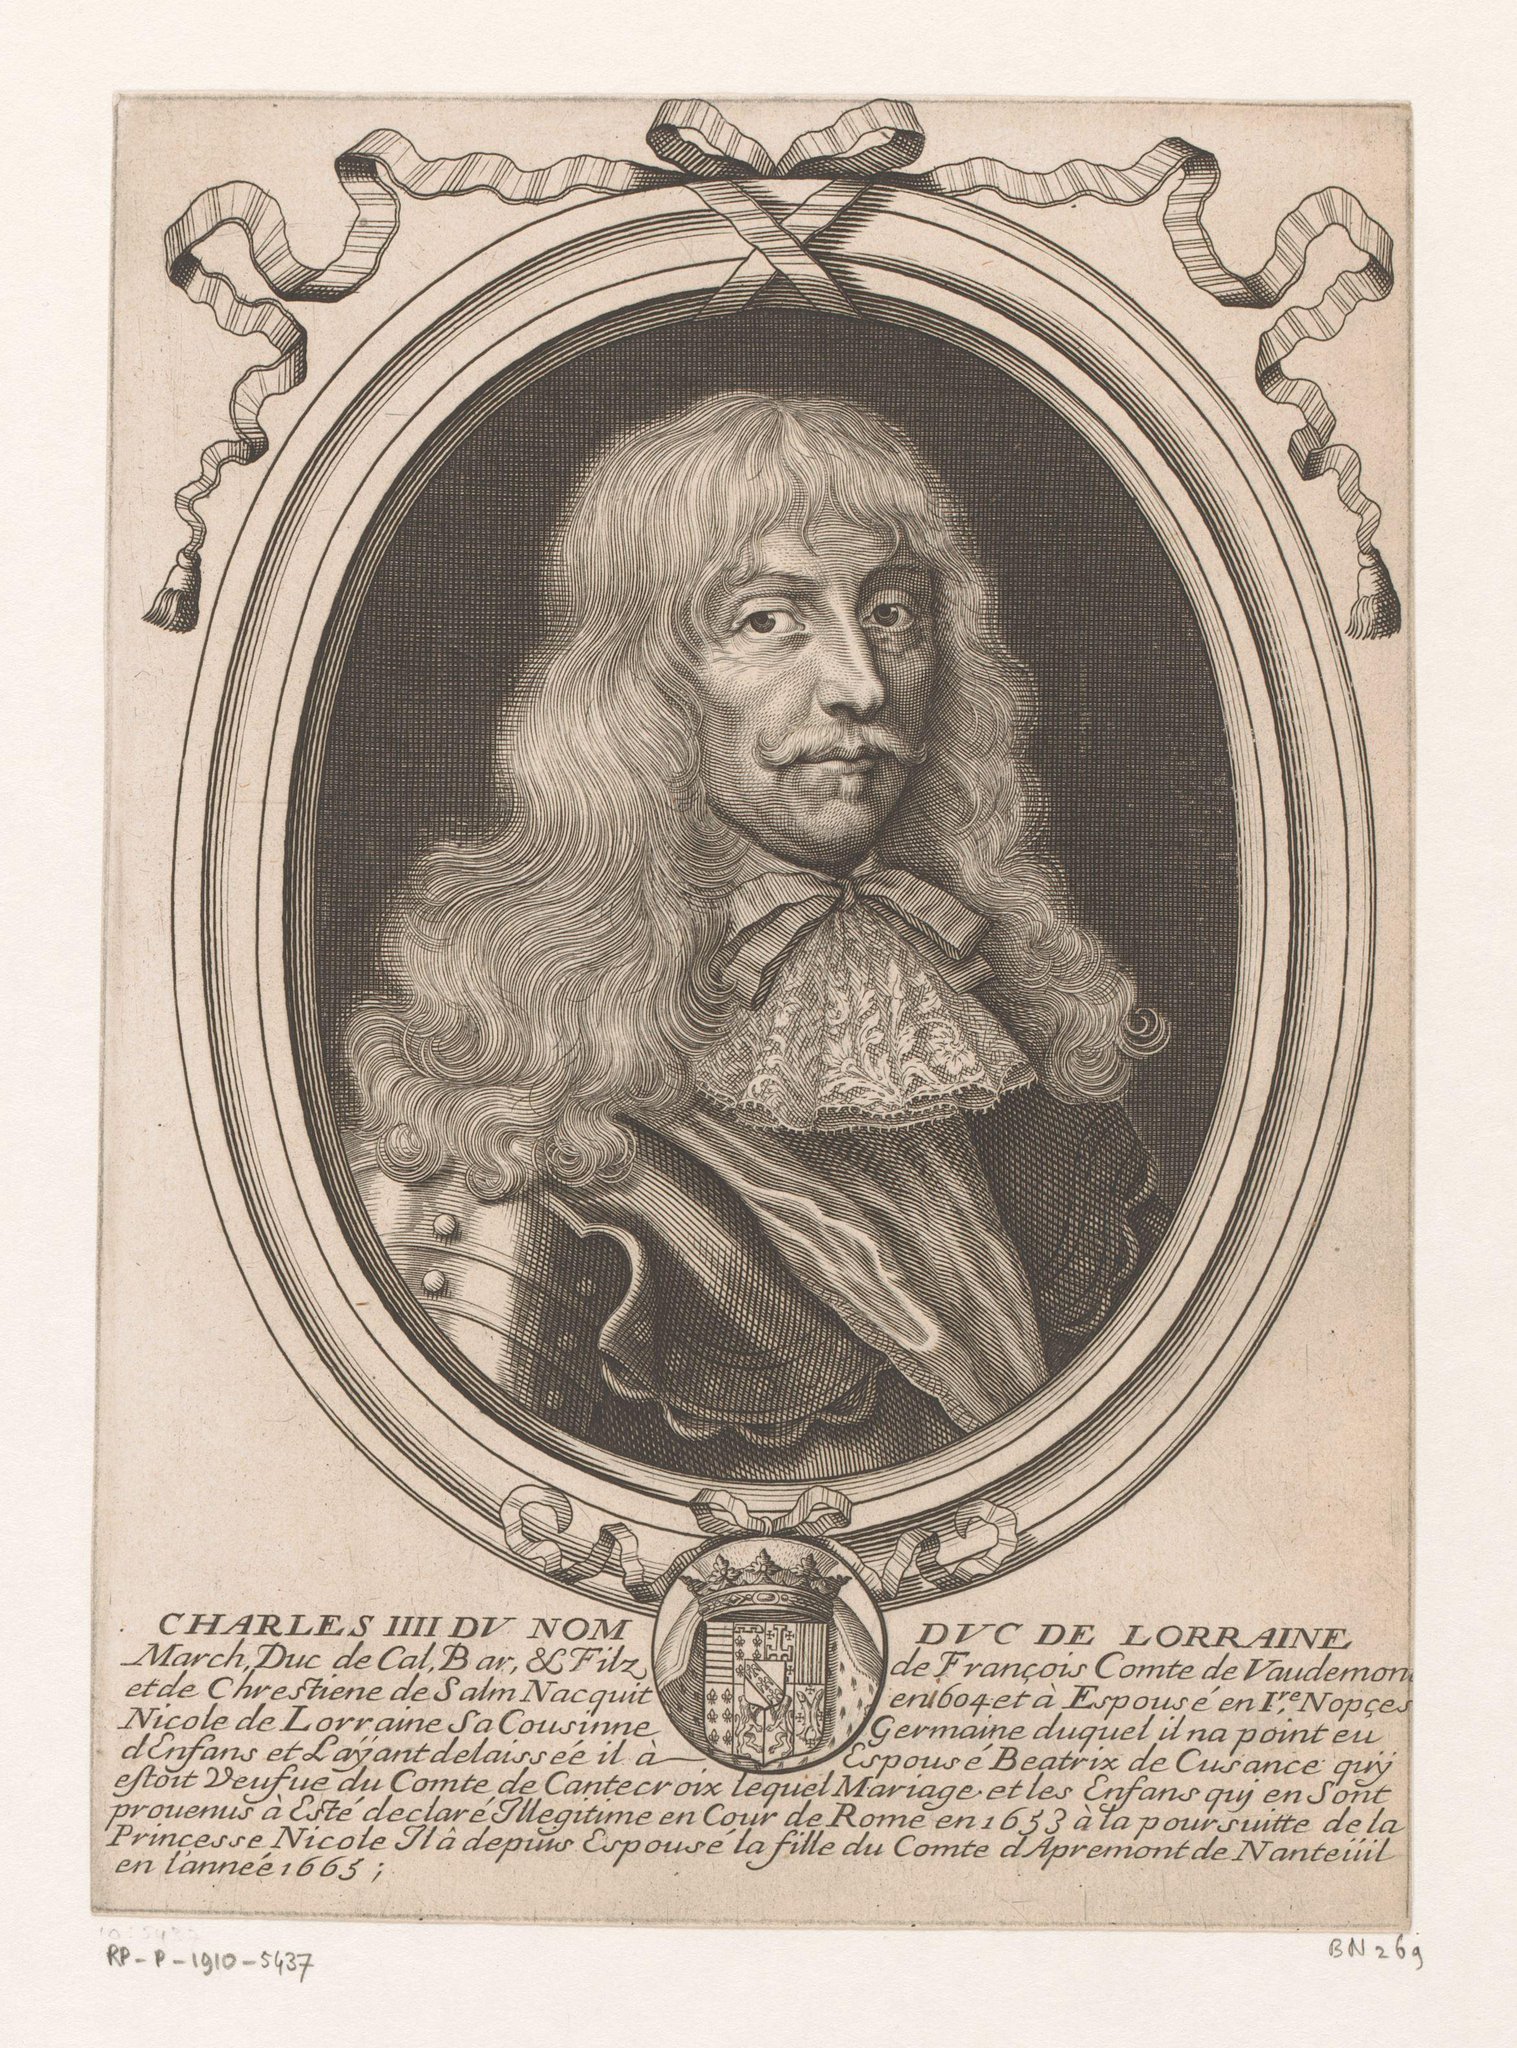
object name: print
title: Portretten van prominente figuren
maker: nicolas de larmessin (i)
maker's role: print maker, publisher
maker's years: 1632-1694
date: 1642-1694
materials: paper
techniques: engraving, etching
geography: france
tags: karel iv hertog van lotharingen, historical persons, nobility and patriciate; chivalry, knighthood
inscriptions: collector's mark: Lugt 2228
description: Maakt deel uit van een grootschalige serie met portretten van prominente figuren. Binnen de serie bevindt zich een sectie getiteld 'Les Augustes Représentations De tous les Roys De France depuis Pharamond Iusqu'à Louys XIIII'. De serie werd respectievelijk uitgegeven door Pierre Bertrand, door zijn weduwe en door De Larmessin zelf.